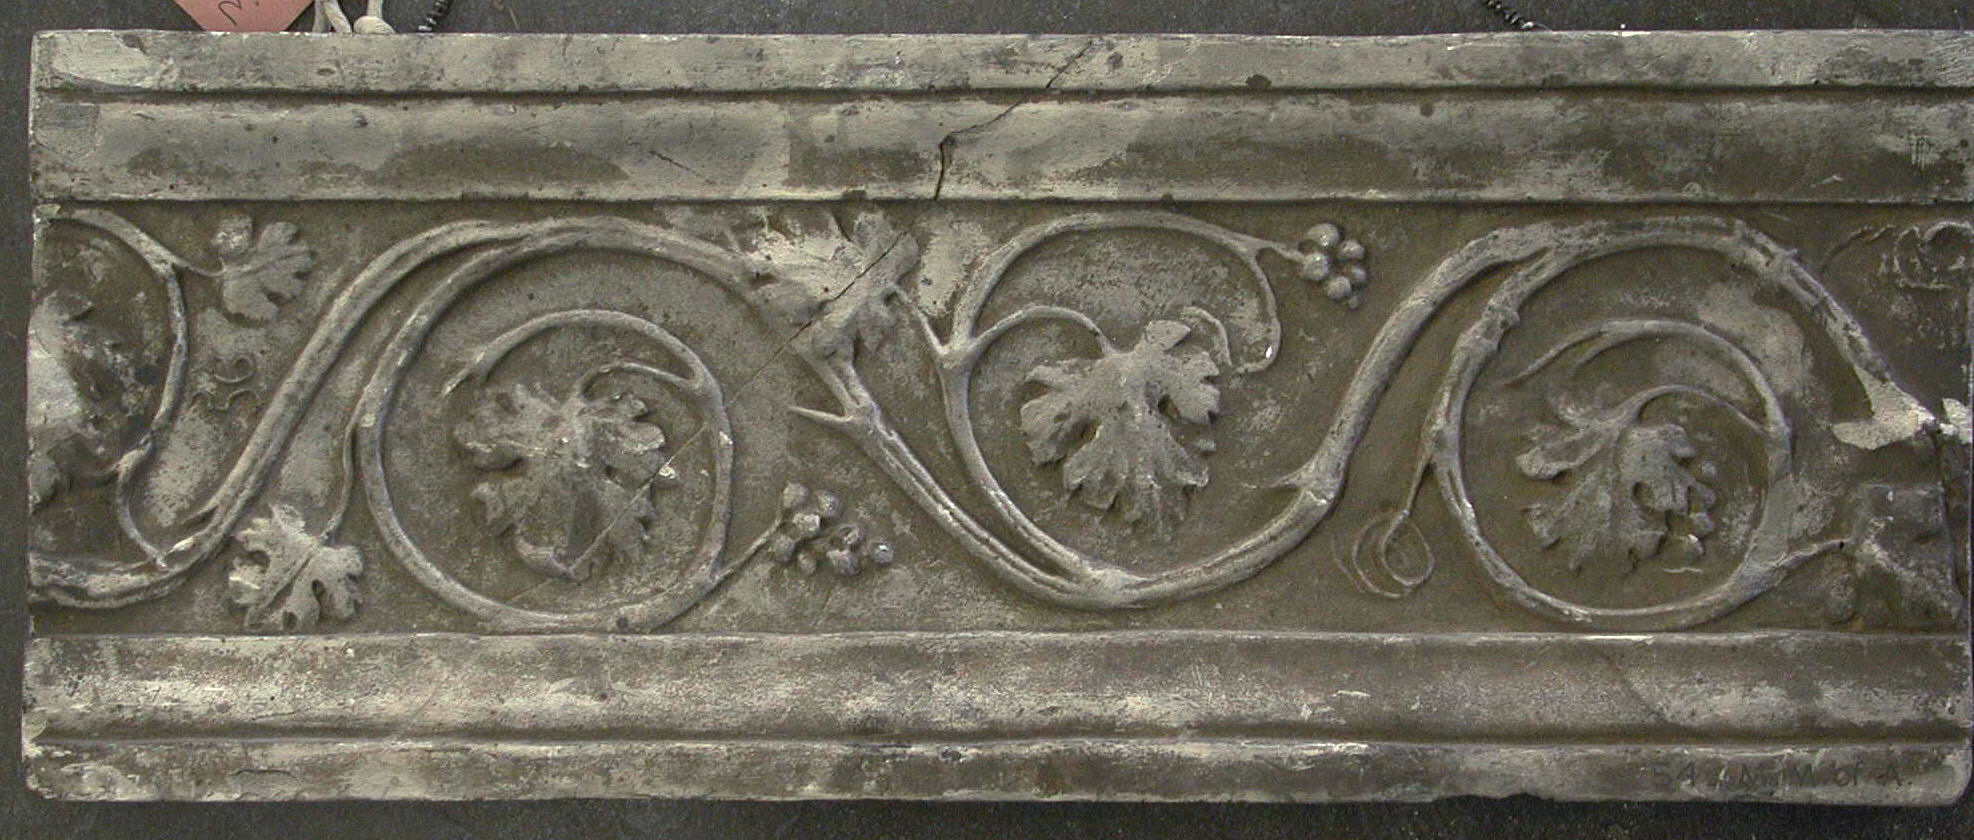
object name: cast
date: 1801-1900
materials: plaster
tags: leaves